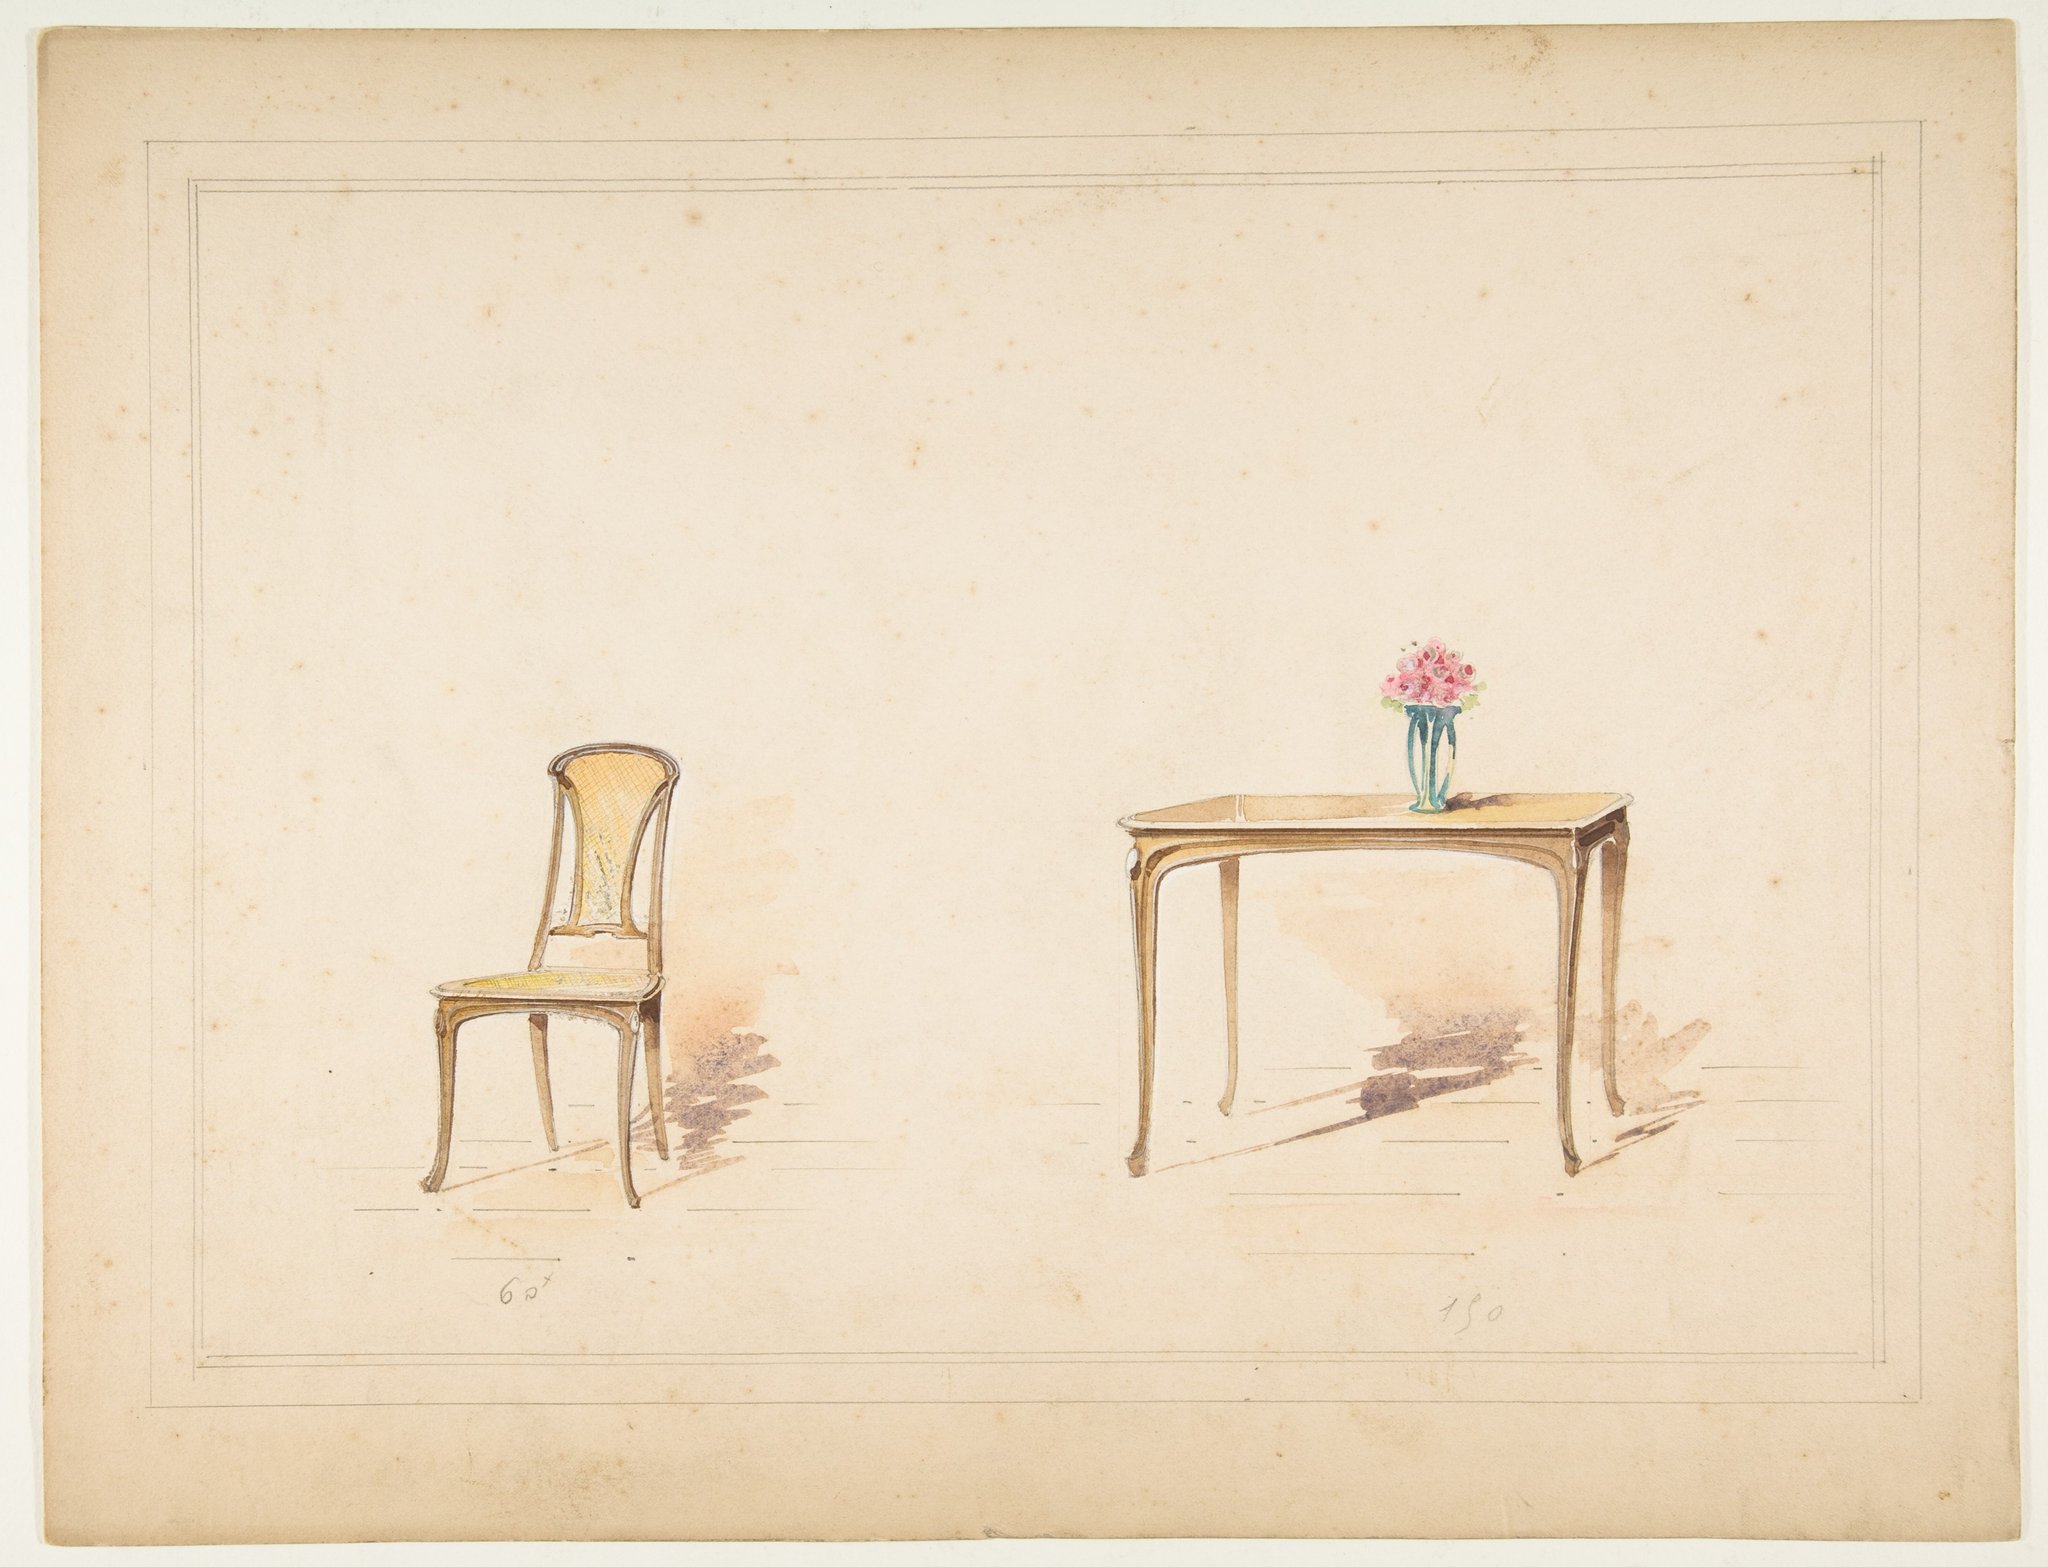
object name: drawing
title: Designs for an Art Nouveau Table and Chair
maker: anonymous, french, 19th century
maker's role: artist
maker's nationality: french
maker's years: 1800-1900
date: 1801-1900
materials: gouache, graphite, watercolor, paper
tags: chairs,tables